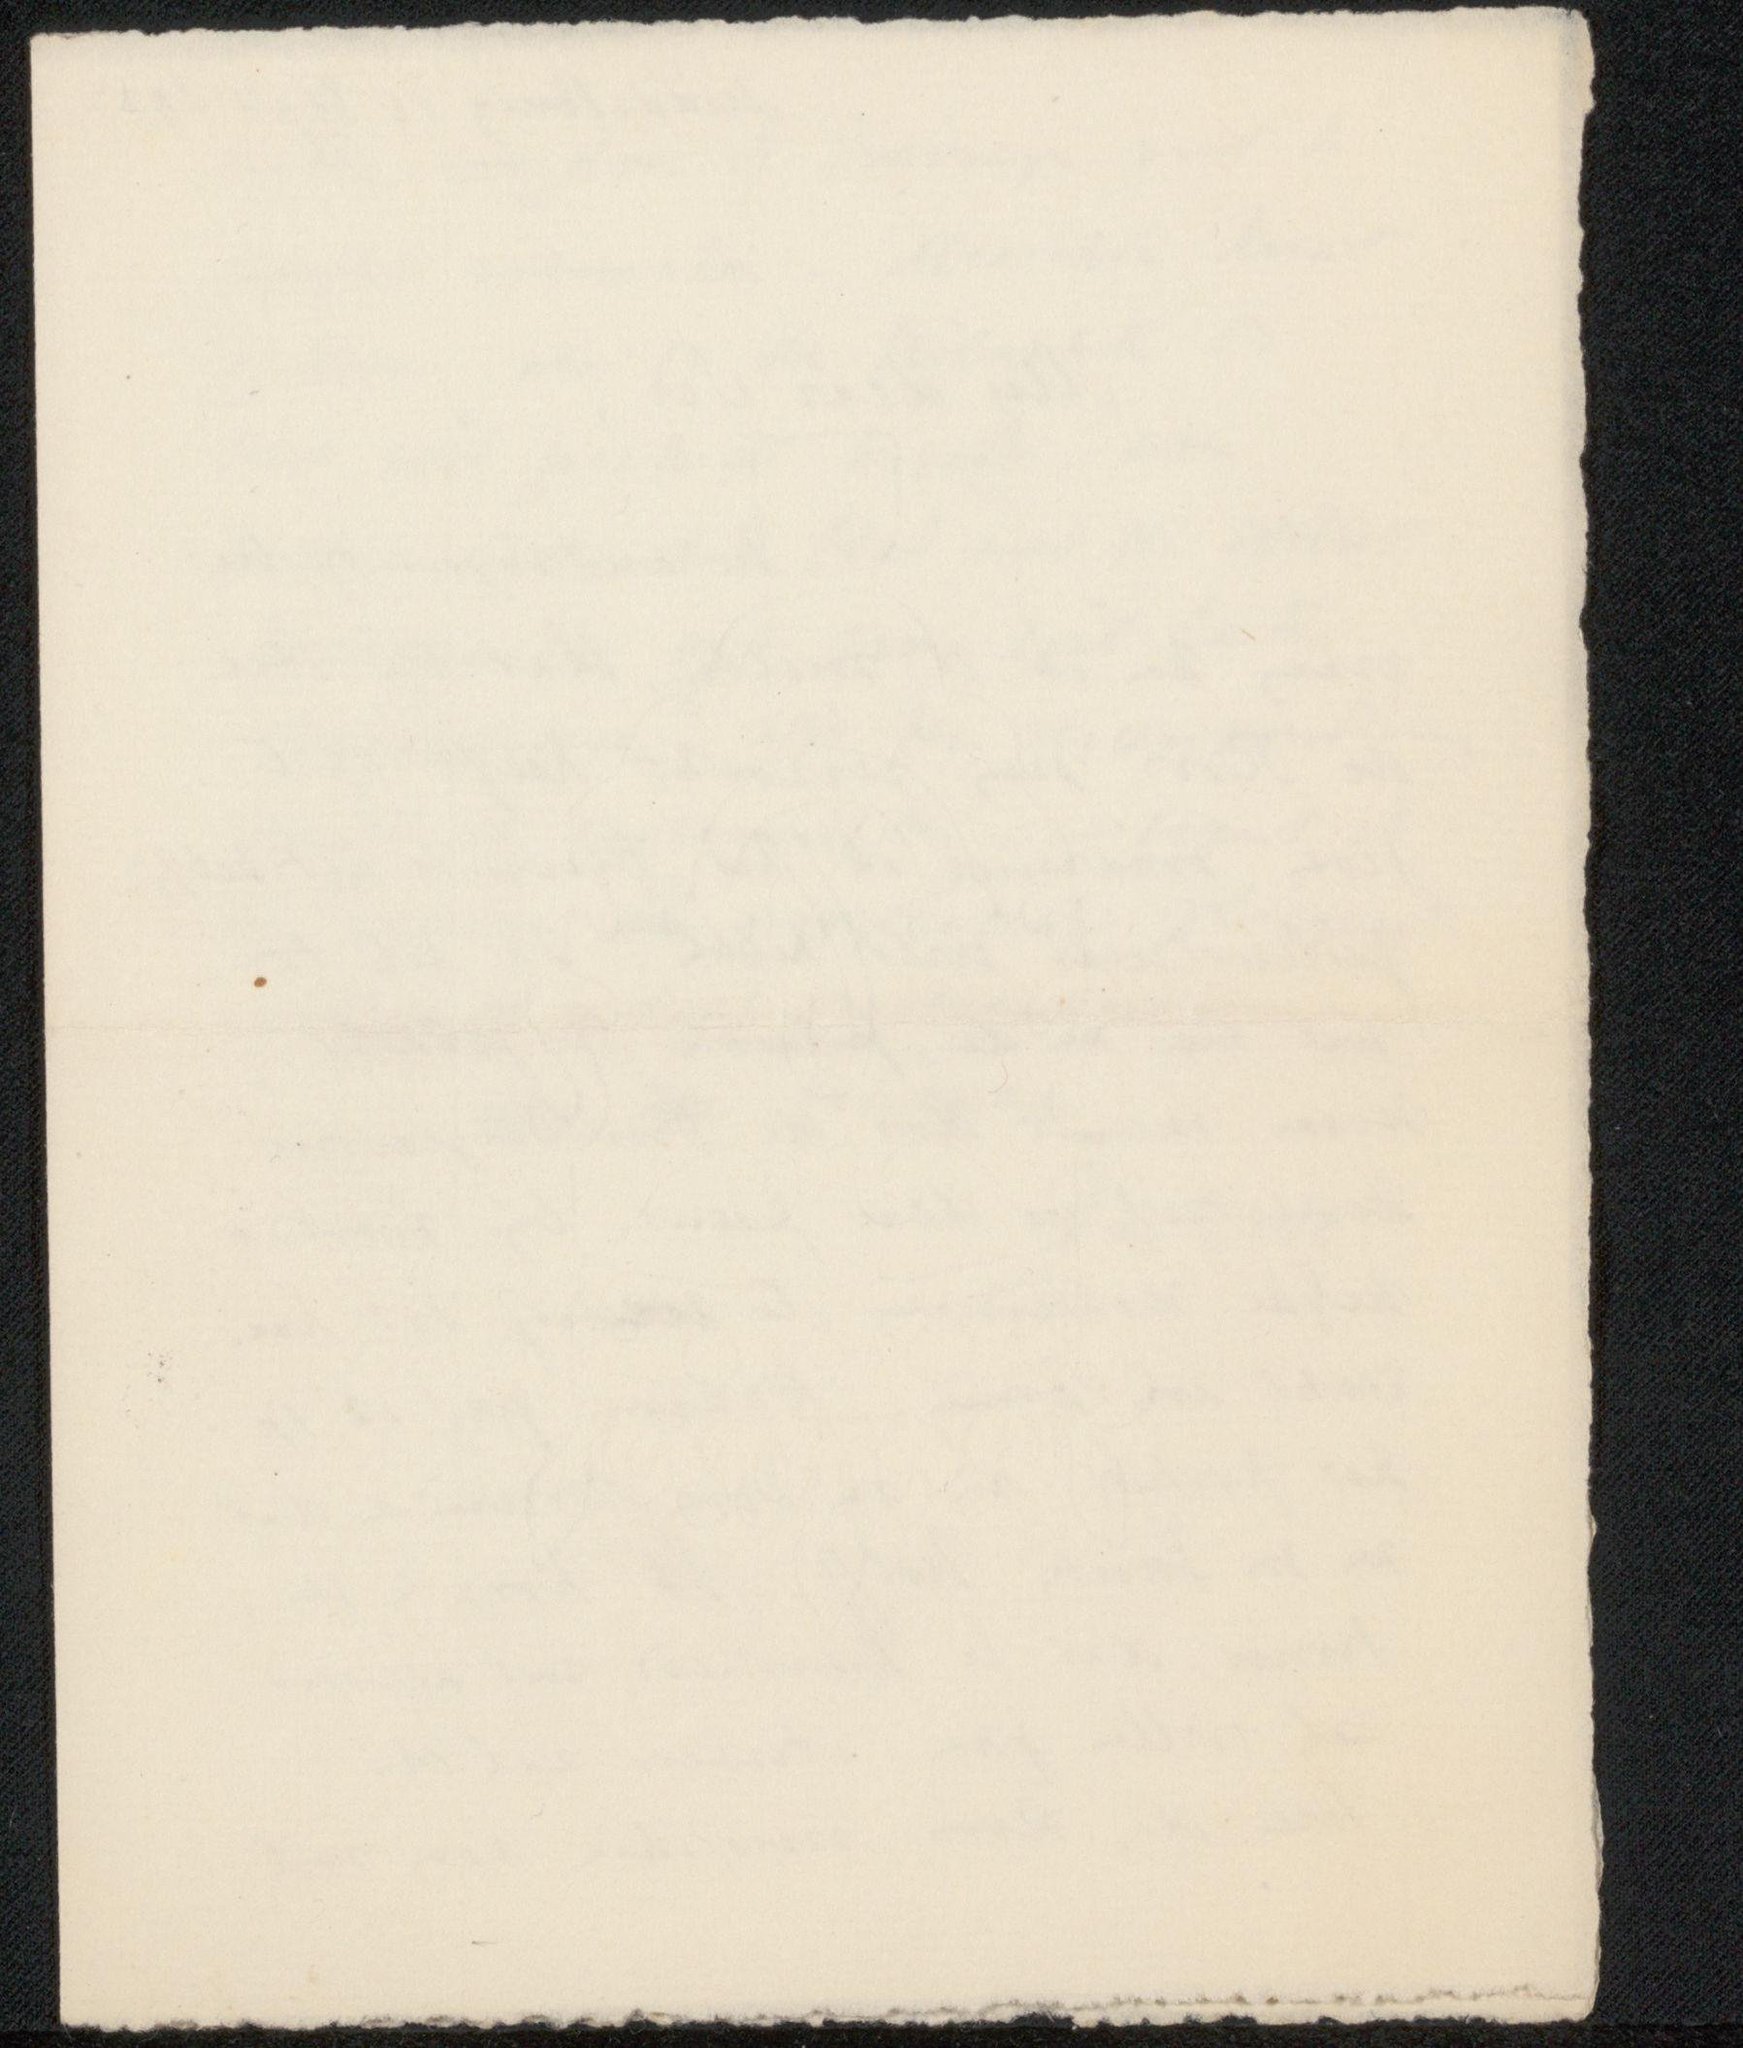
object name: letter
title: Brief aan August Allebé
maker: jan veth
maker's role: designer, draughtsman, painter, print maker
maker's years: 1864-1925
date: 1917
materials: ink, paper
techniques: pen, writing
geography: middelburg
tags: august allebé, sjoerd hendrik de roos, amsterdam, haarlem, louis van erven dorens, rotterdam, painter, draughtsman, the graphic arts, historical persons (portraits and scenes from the life), printed matter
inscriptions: watermark, collector's mark: ‘RPK’